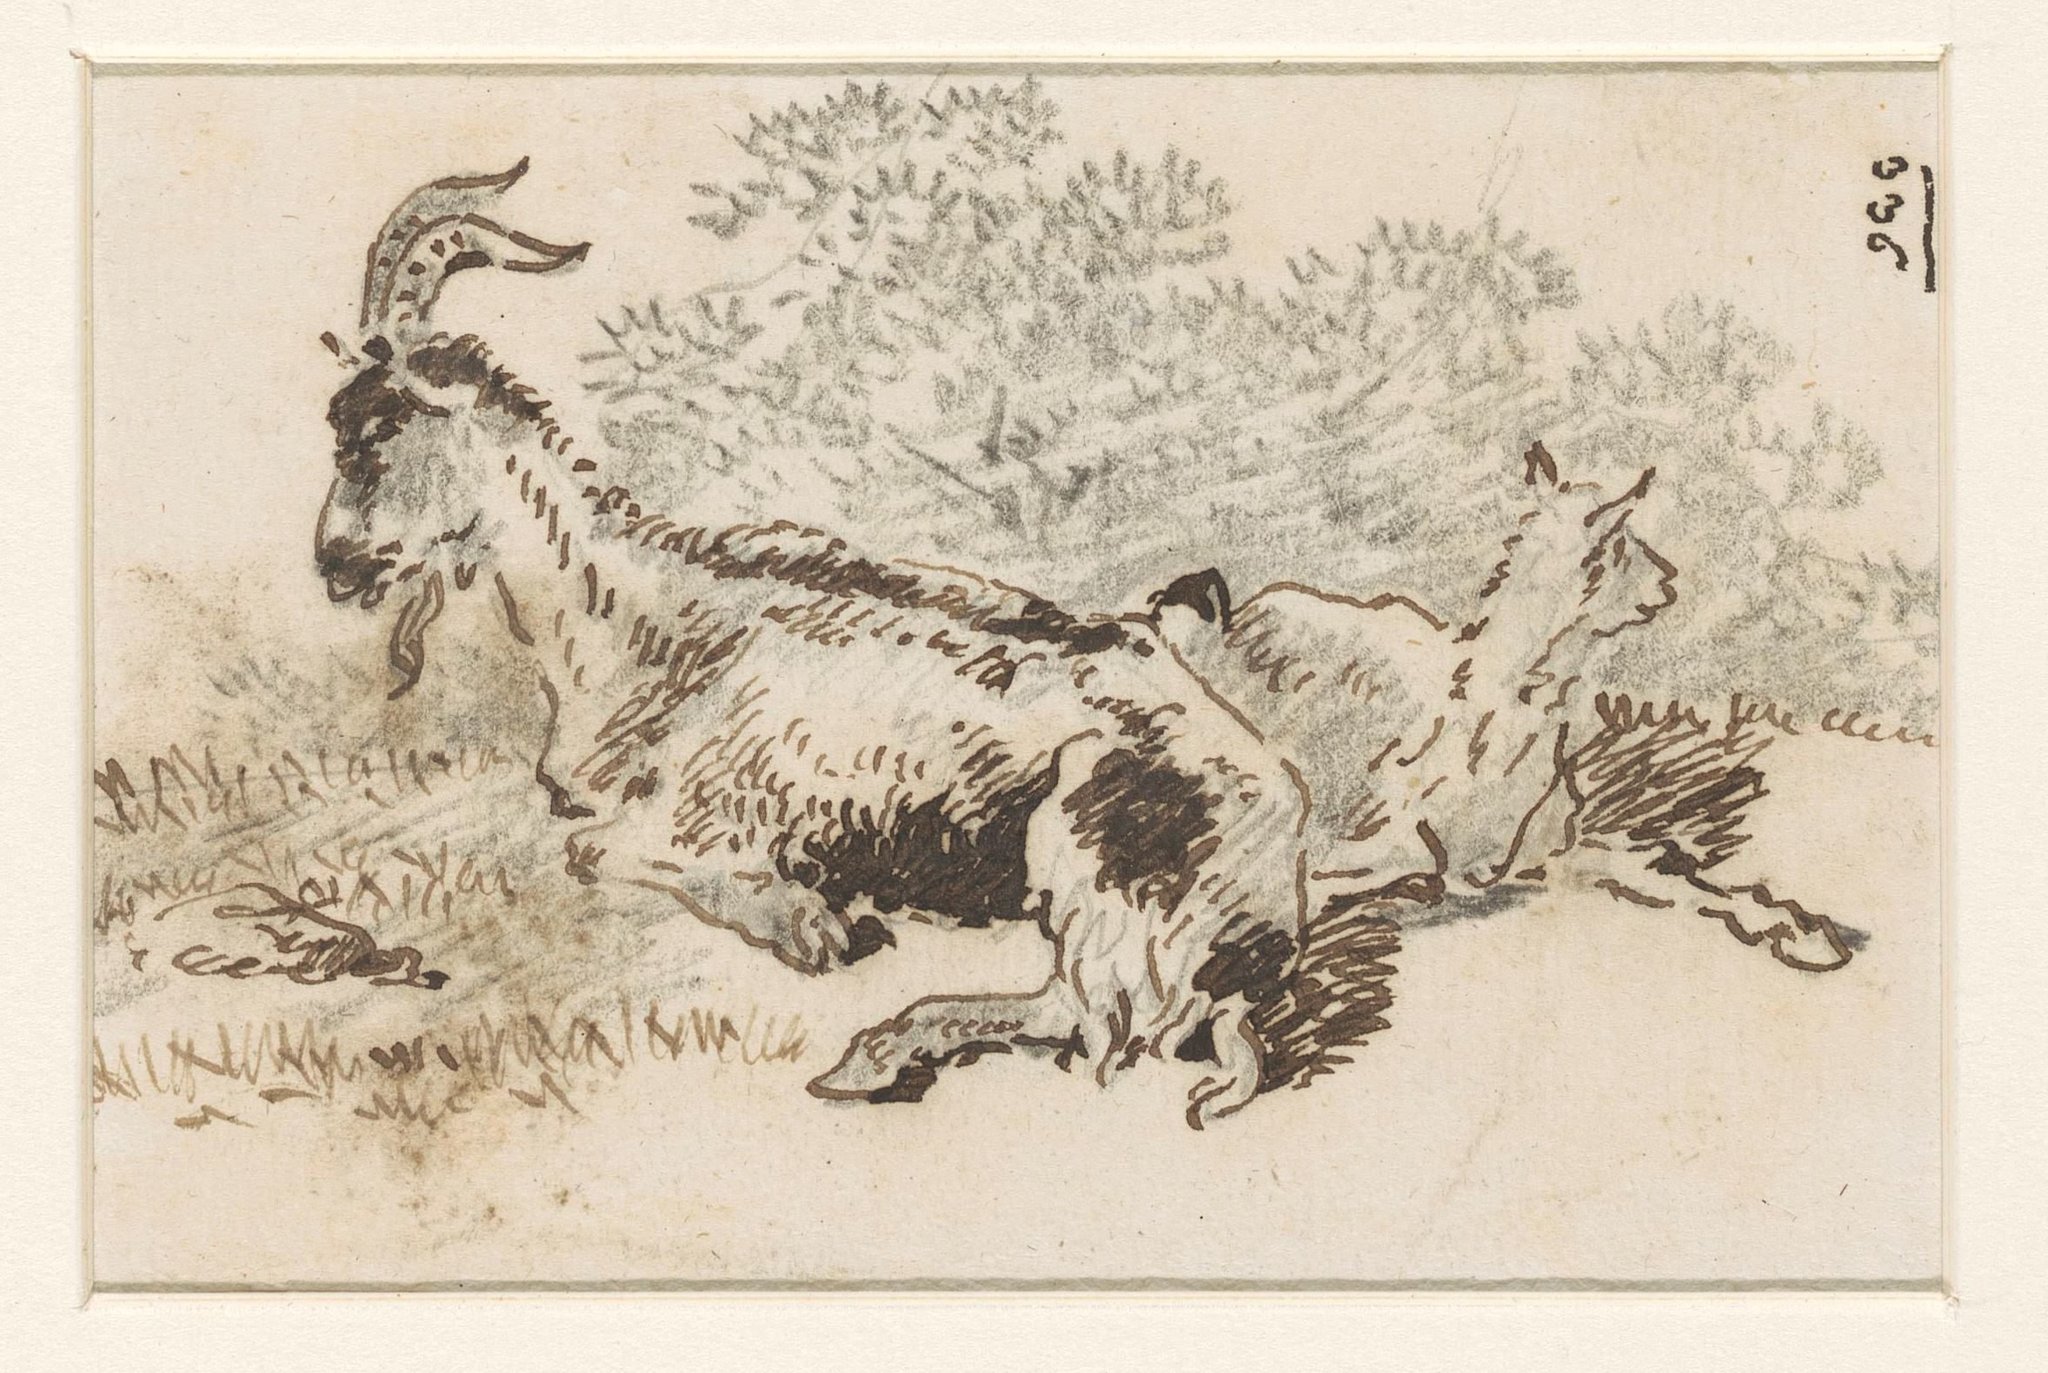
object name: drawing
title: Geit en jong in een landschap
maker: david alphonse de sandoz-rollin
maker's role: draughtsman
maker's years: 1740-1809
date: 1750-1809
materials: ink, paper, pencil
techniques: pen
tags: goat